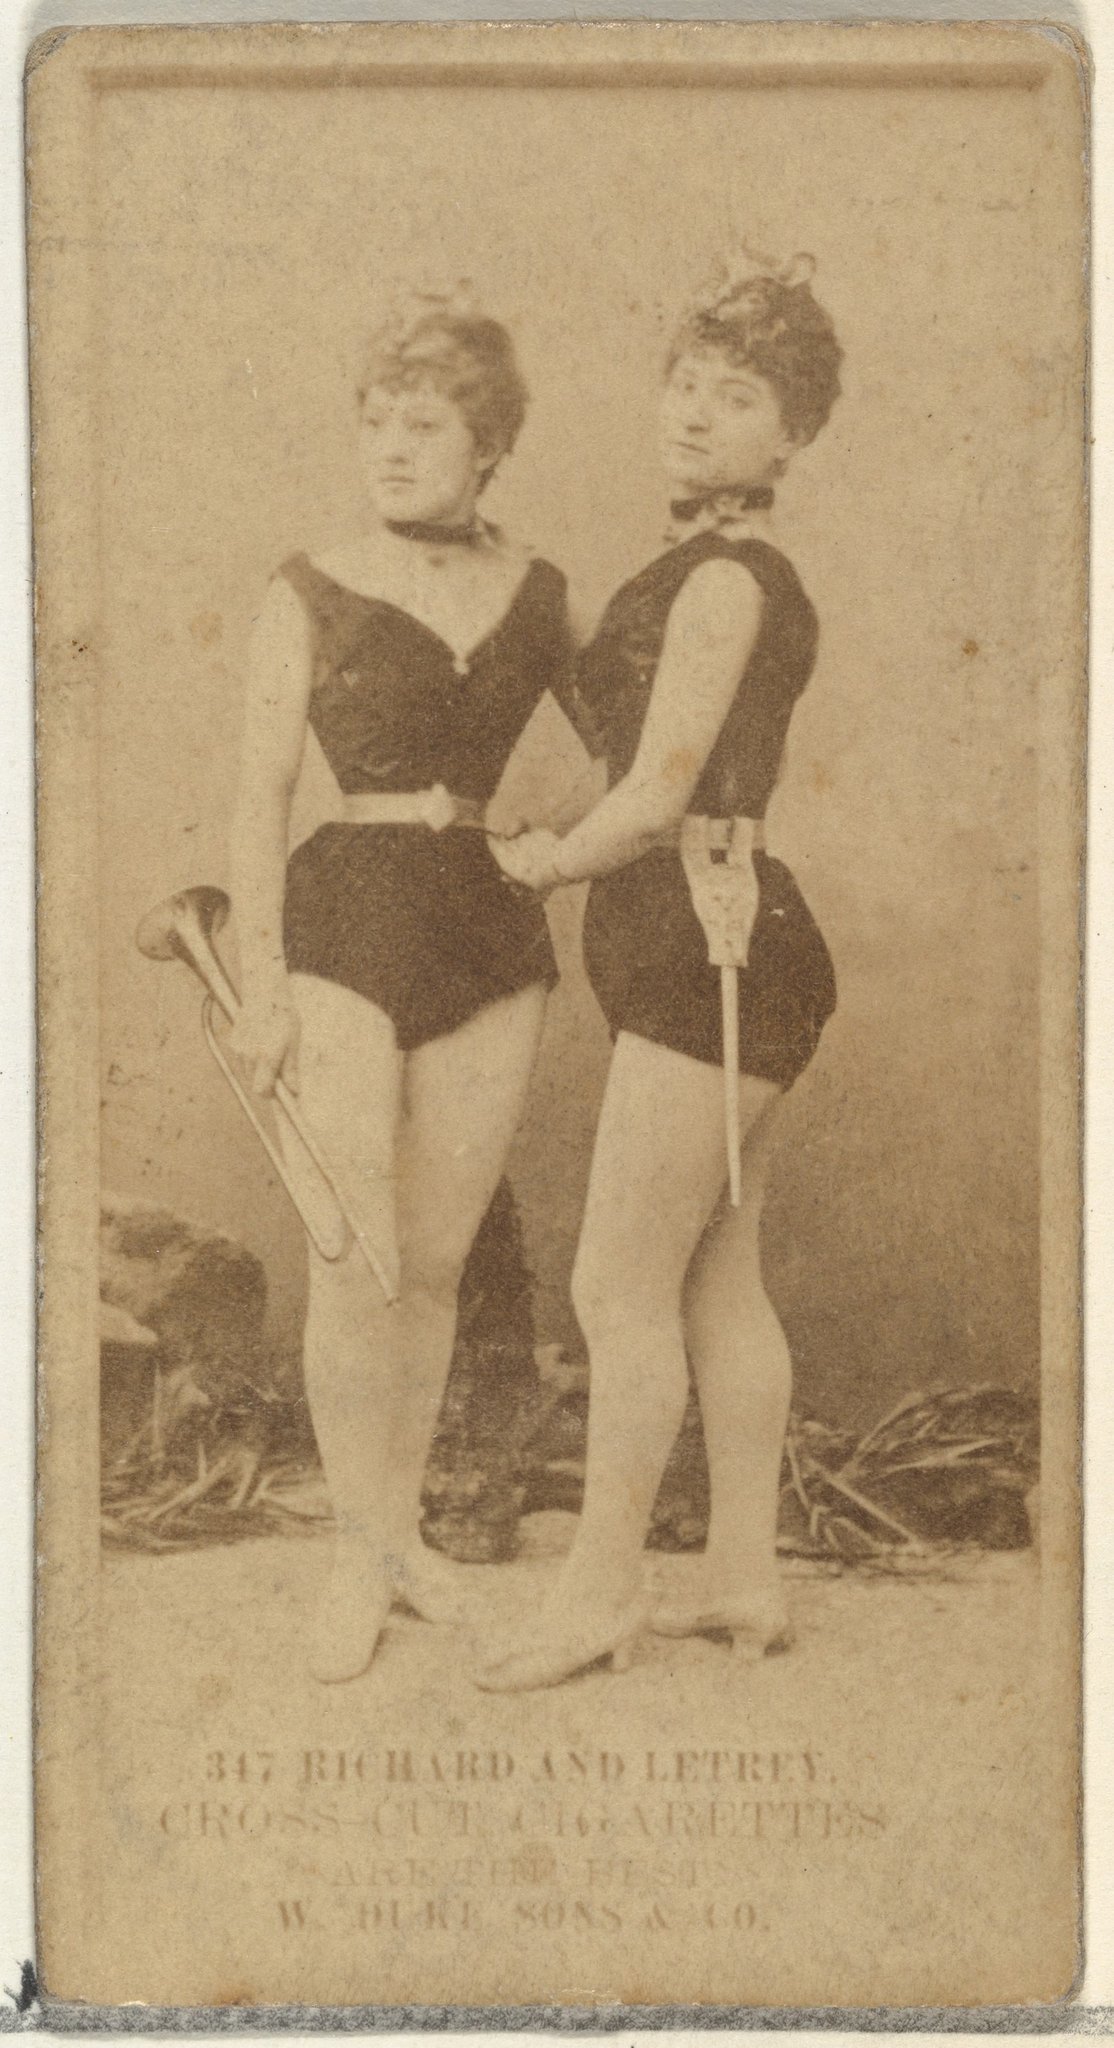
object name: photograph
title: Card Number 347, Richard and Letrey, from the Actors and Actresses series (N145-3) issued by Duke Sons & Co. to promote Cross Cut Cigarettes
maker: w. duke, sons & co.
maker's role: publisher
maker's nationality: american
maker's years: 1870-1920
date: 1880-1889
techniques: albumen silver print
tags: portraits,women,actresses